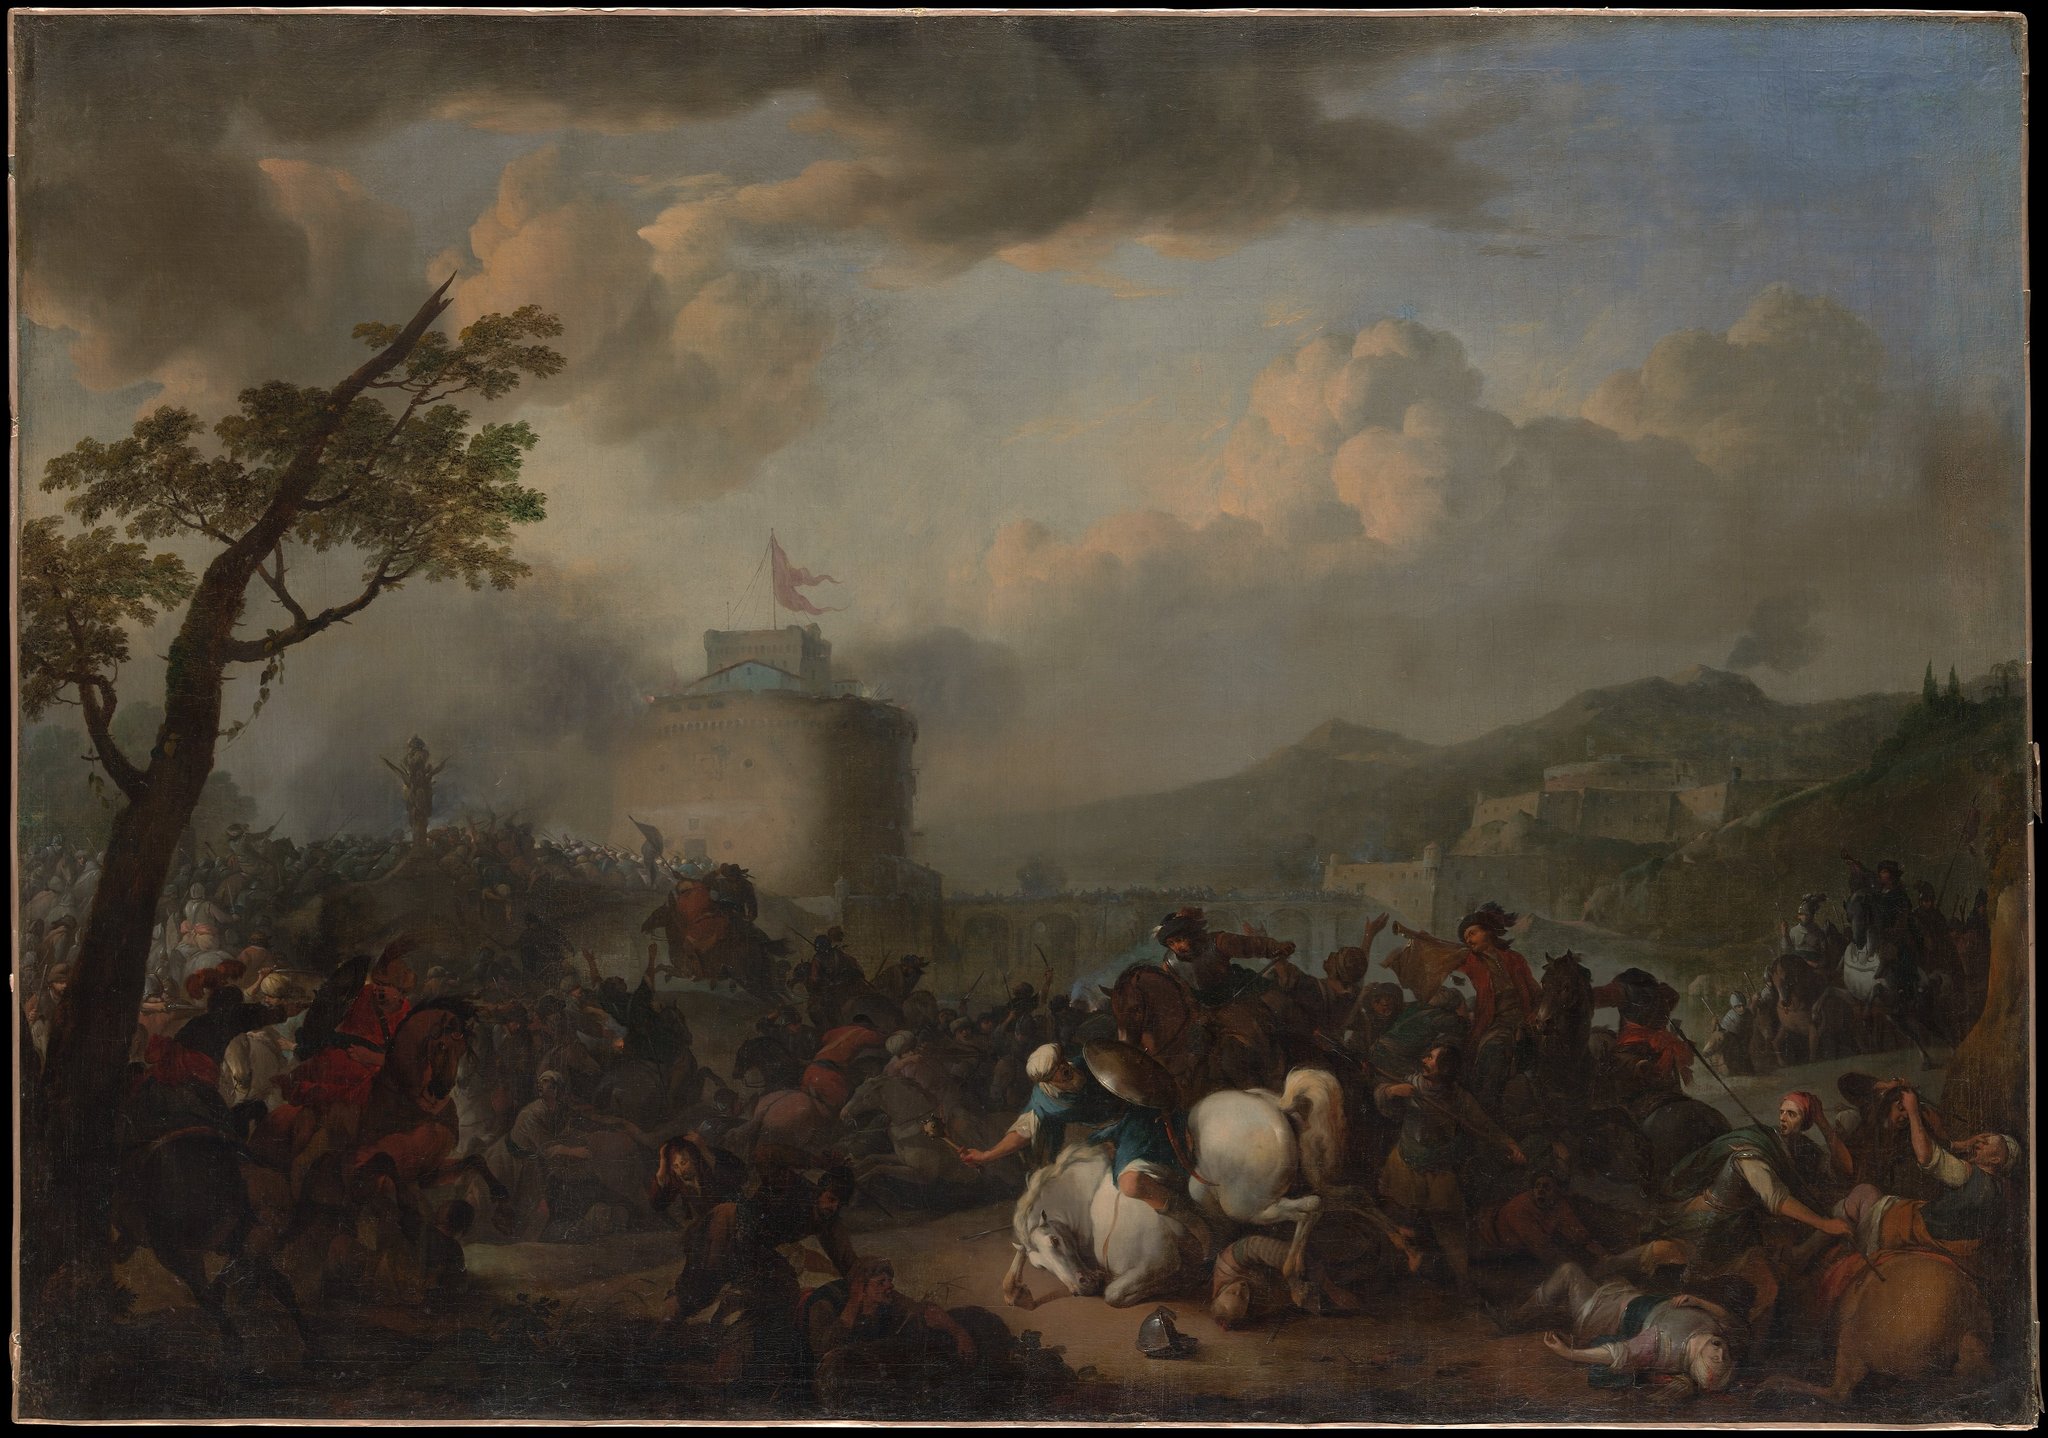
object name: painting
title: Battle Scene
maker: johannes lingelbach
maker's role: artist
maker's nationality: dutch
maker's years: 1622-1674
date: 1671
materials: canvas, oil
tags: battles,soldiers,men,horses